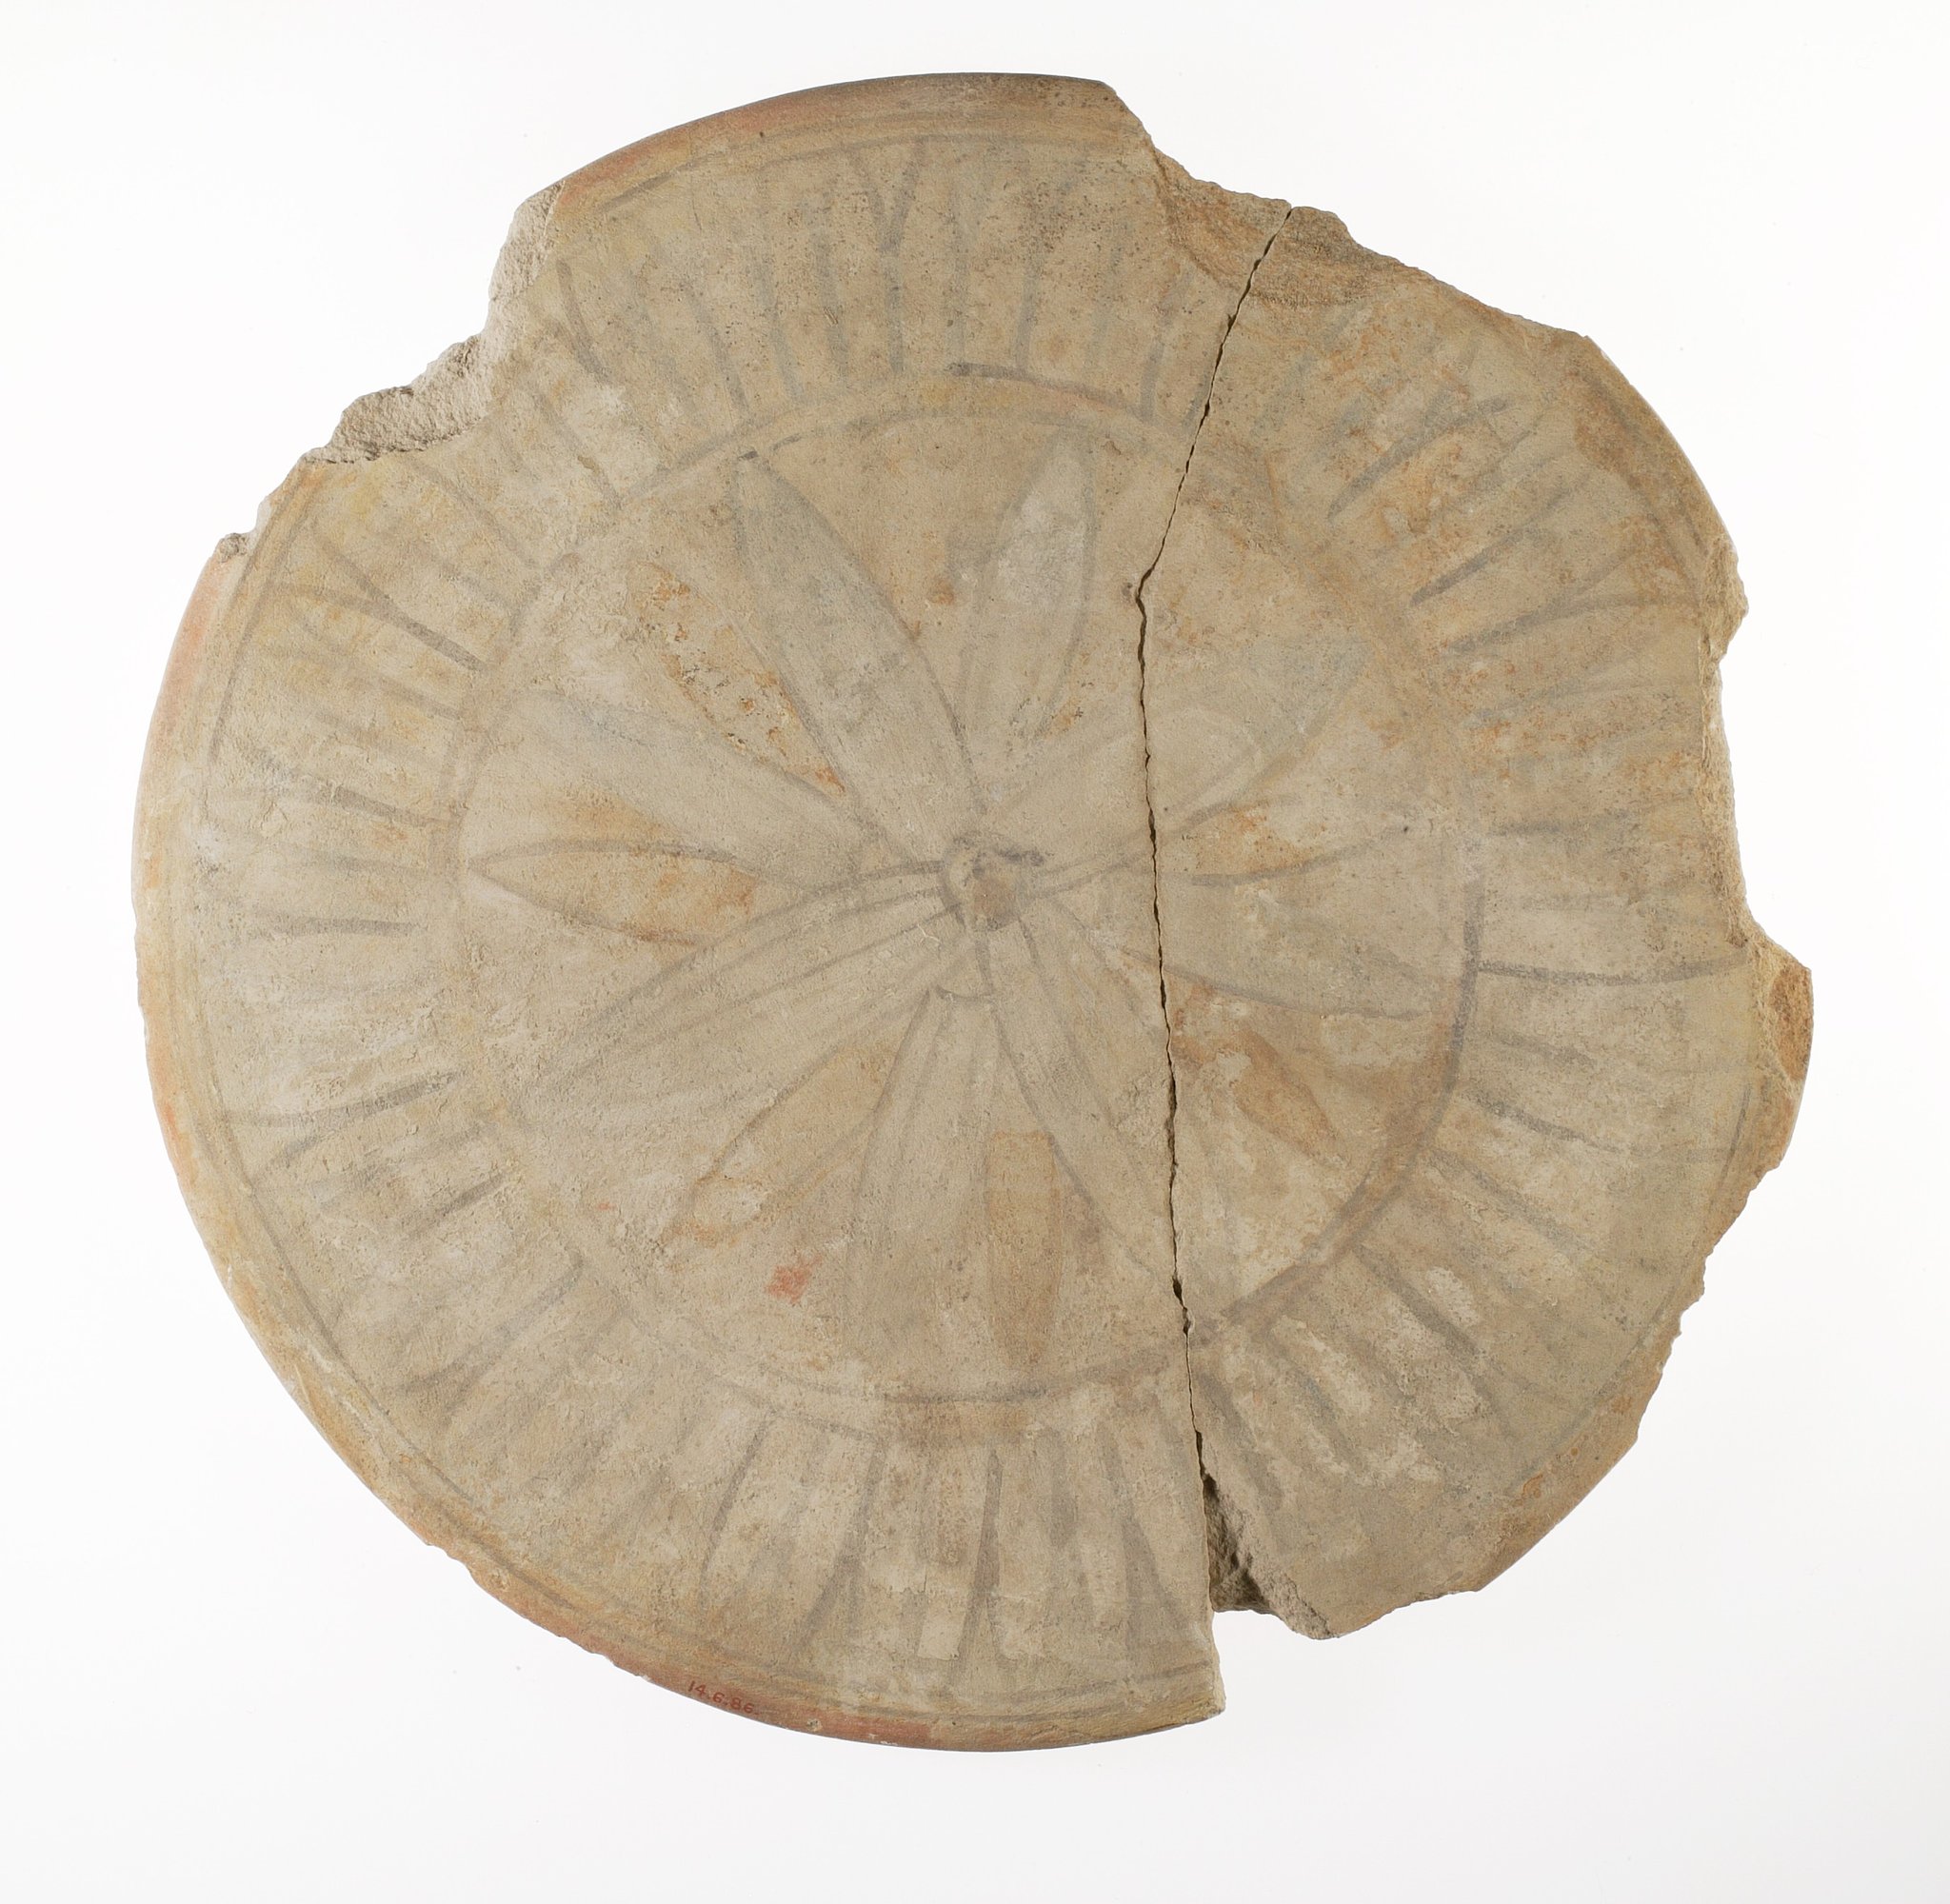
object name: jar lid, siptah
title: Disk-shaped Jar Lid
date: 1194-1188 BCE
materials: limestone, paint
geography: egypt